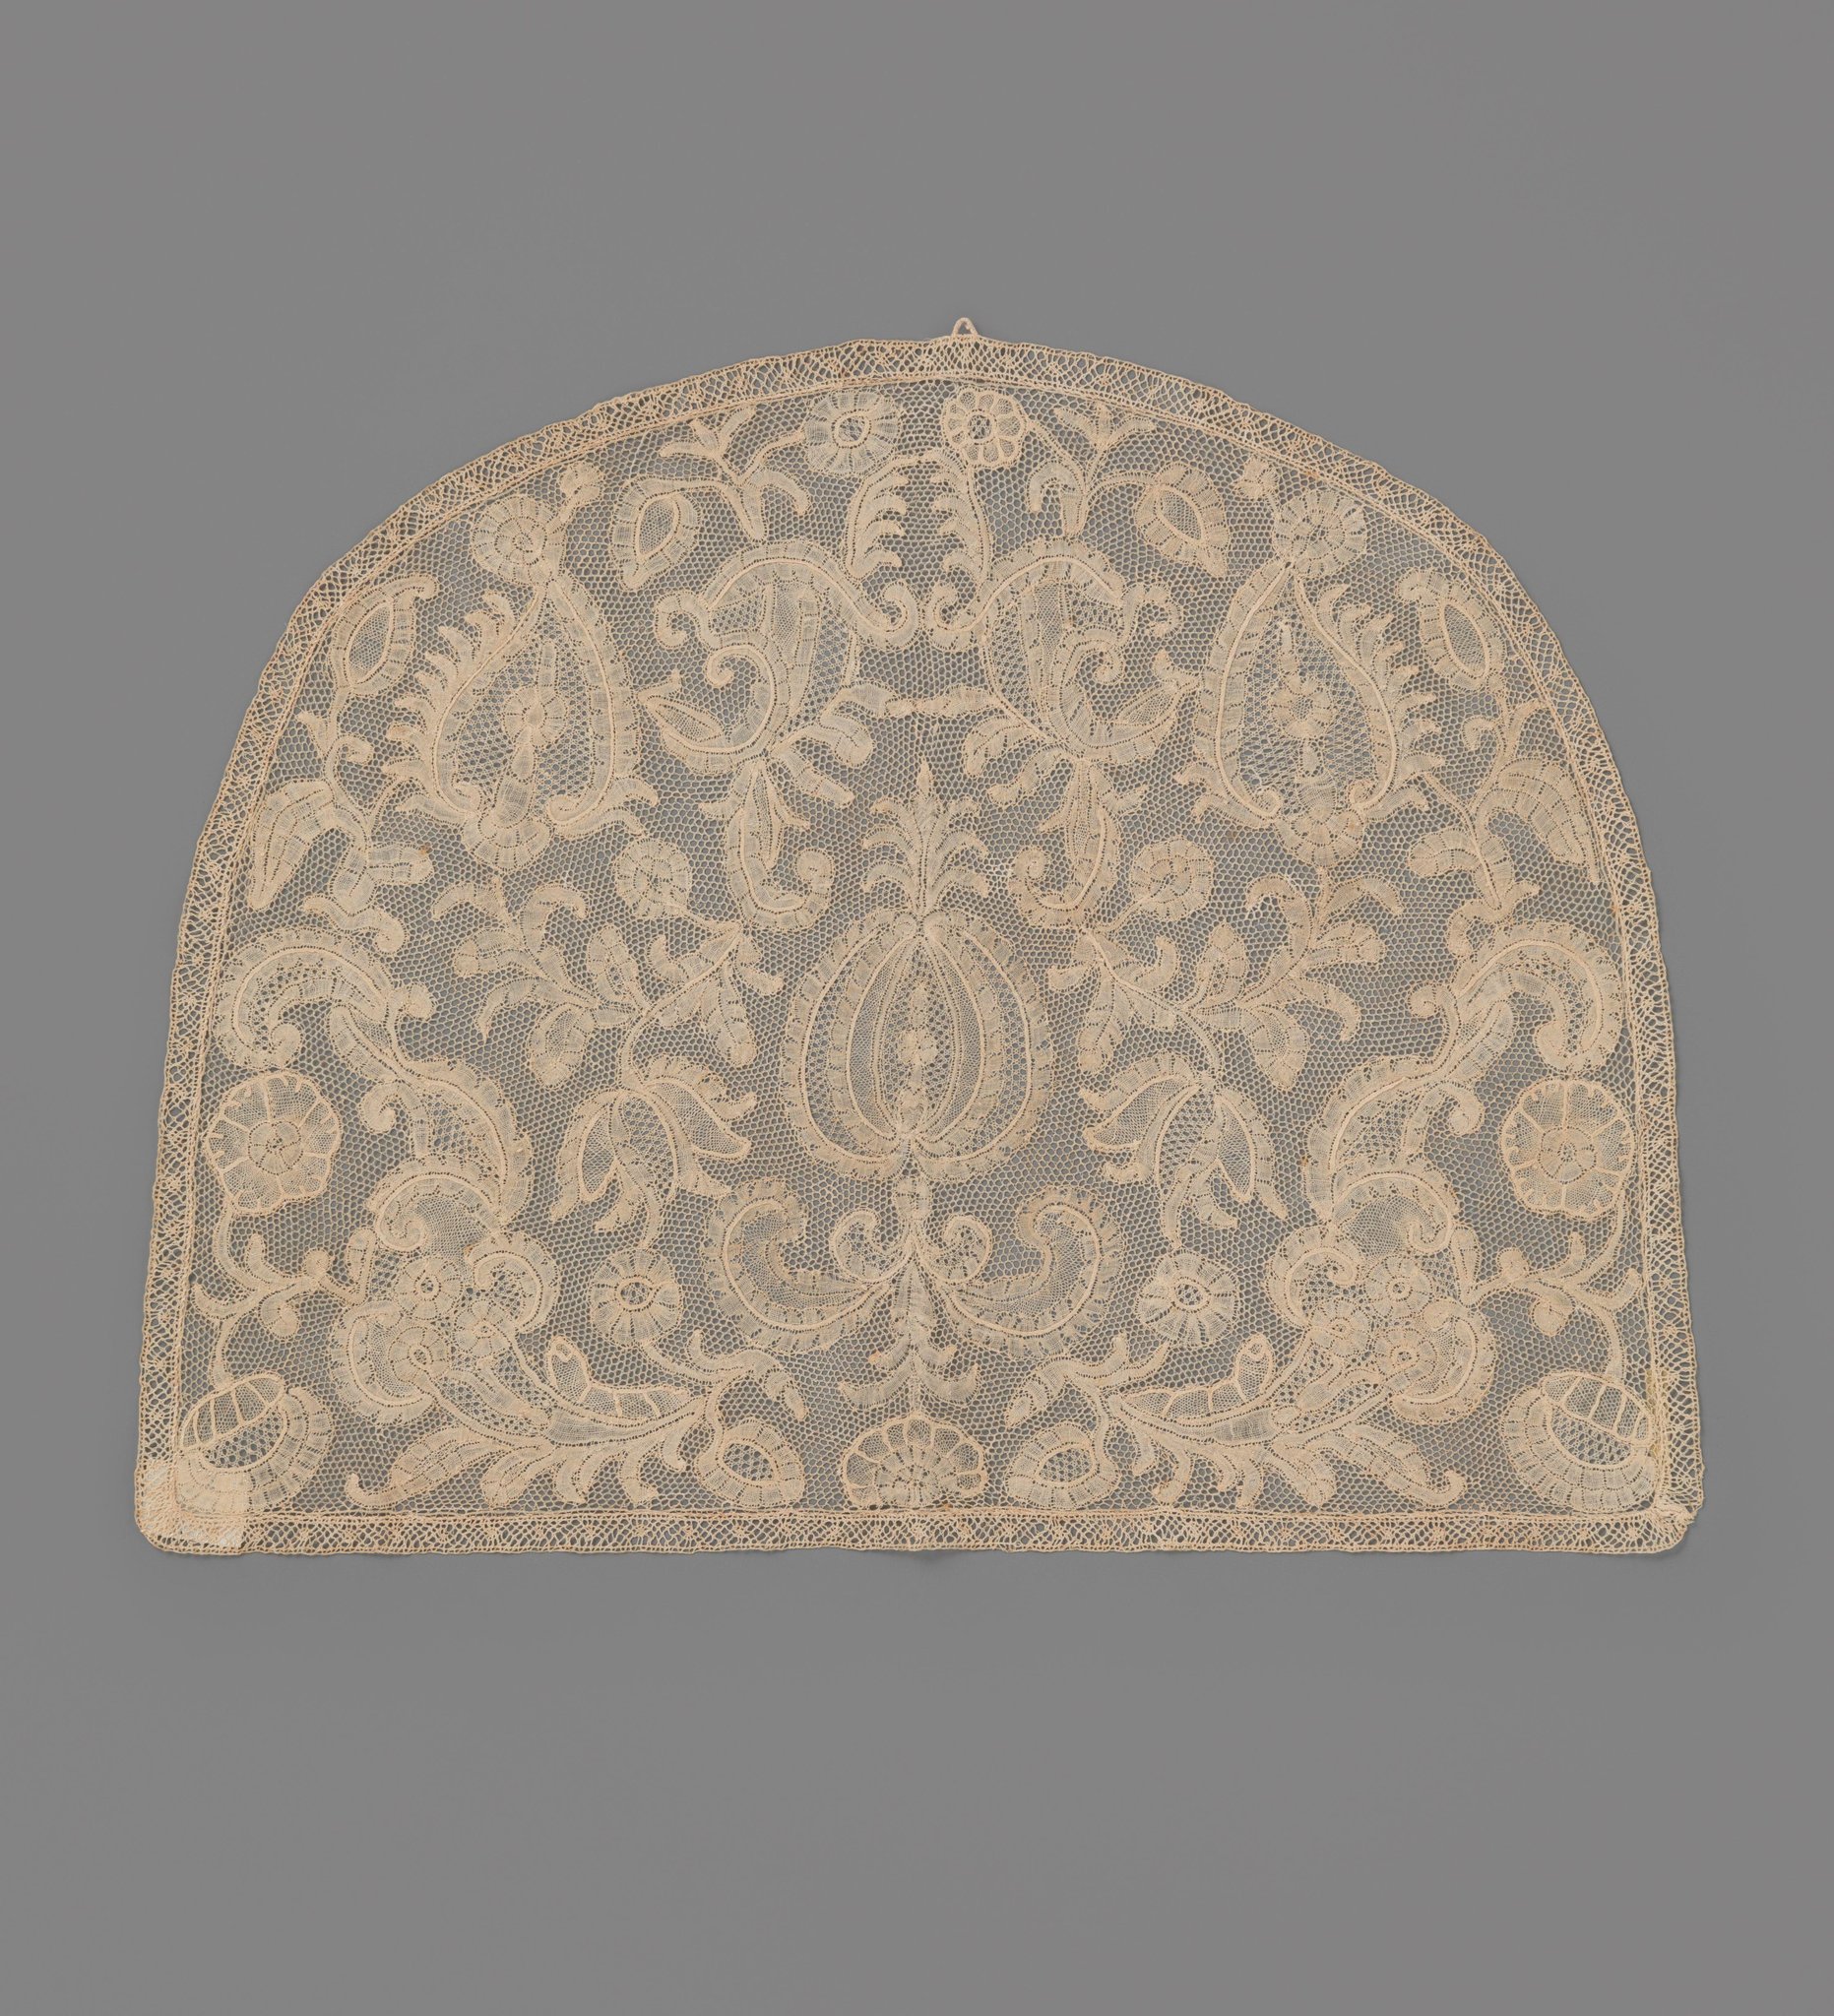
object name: womenswear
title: Mutsenbol van Brusselse kloskant (vieux Bruxelles)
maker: Anonymous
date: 1725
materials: lace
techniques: lace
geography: western europe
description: Mutsenbol van kloskant. Het patroon is symmetrisch en heeft een granaatappel, hoornen van overvloed, tulpen en bladmotieven. Het kant heeft een zandlopermazenfond.